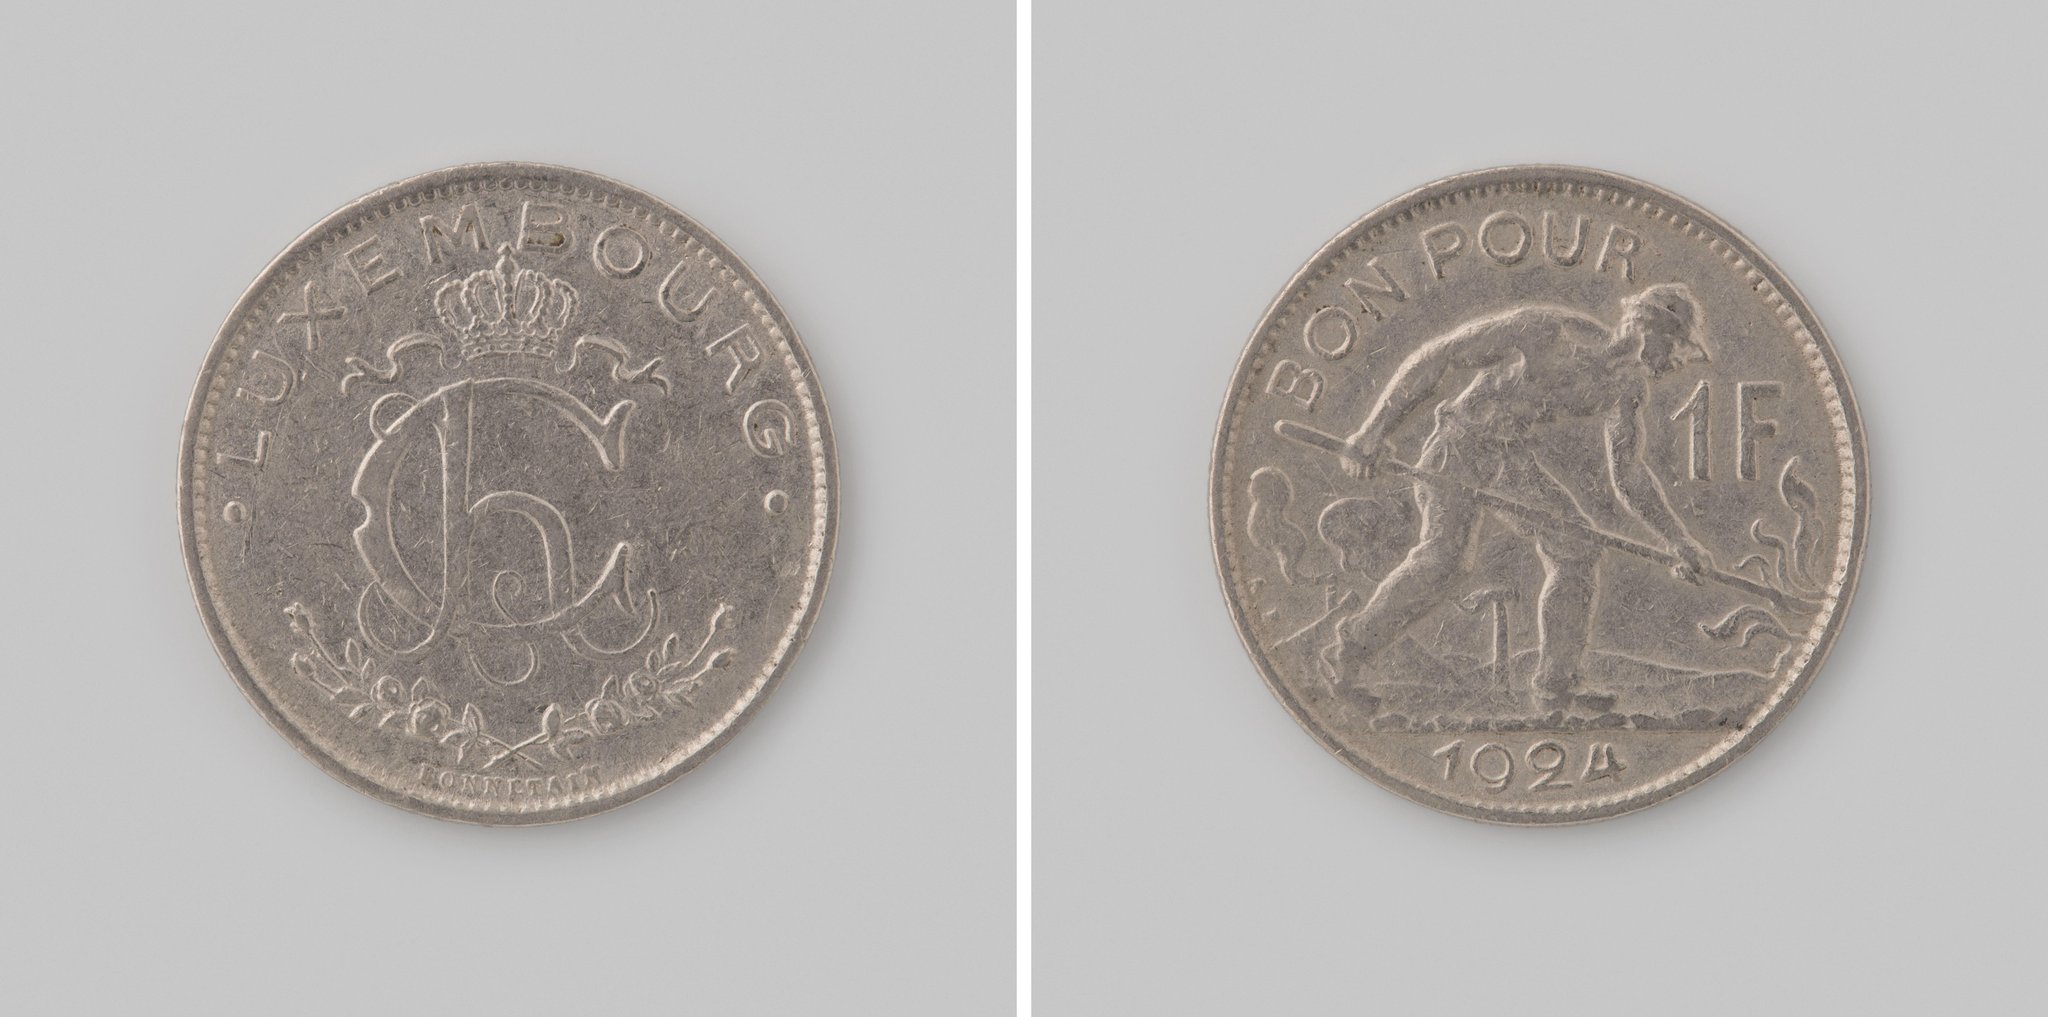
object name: coin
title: Franc uit Luxemburg van Charlotte, 1924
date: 1924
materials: nickel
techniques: striking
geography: brussels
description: Nikkelen munt. Voorzijde: gekroond monogram van de letters C en H. Keerzijde: tegen achtergrond van industriële activiteiten stoker met schep naar rechts. Rechts van hem waarde-aanduiding. Jaartal in afsnede. Kartelrand.